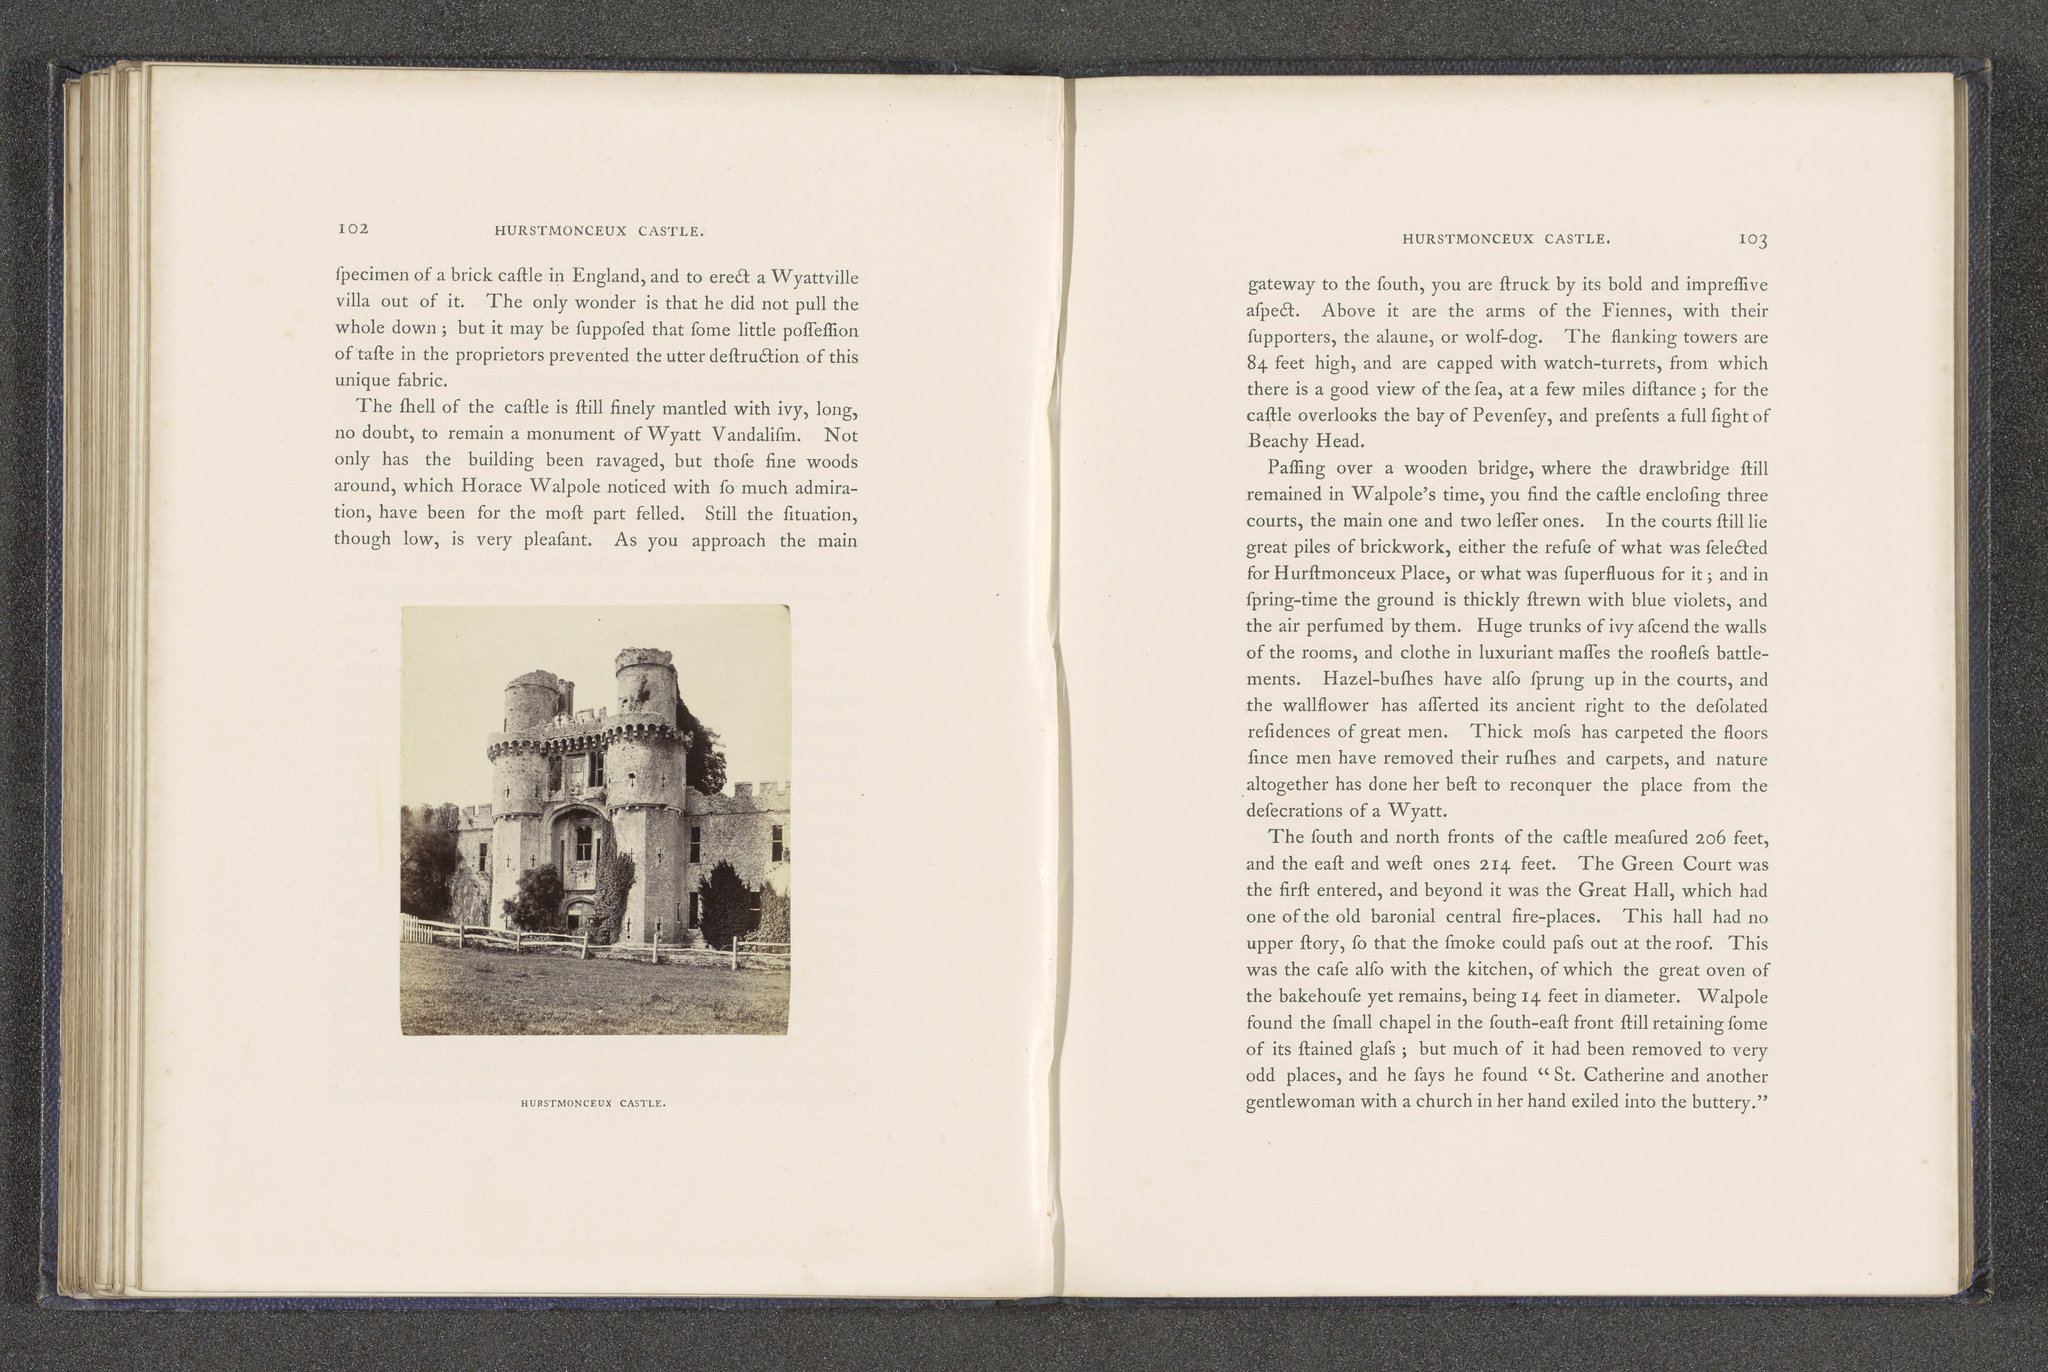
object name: page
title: Hurstmonceux Castle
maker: william russell sedgfield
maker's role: fotograaf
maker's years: 1826-1902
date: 1854-1864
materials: photographic support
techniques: albumen print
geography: herstmonceux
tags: ruin of a dwelling, house, castle, etc.